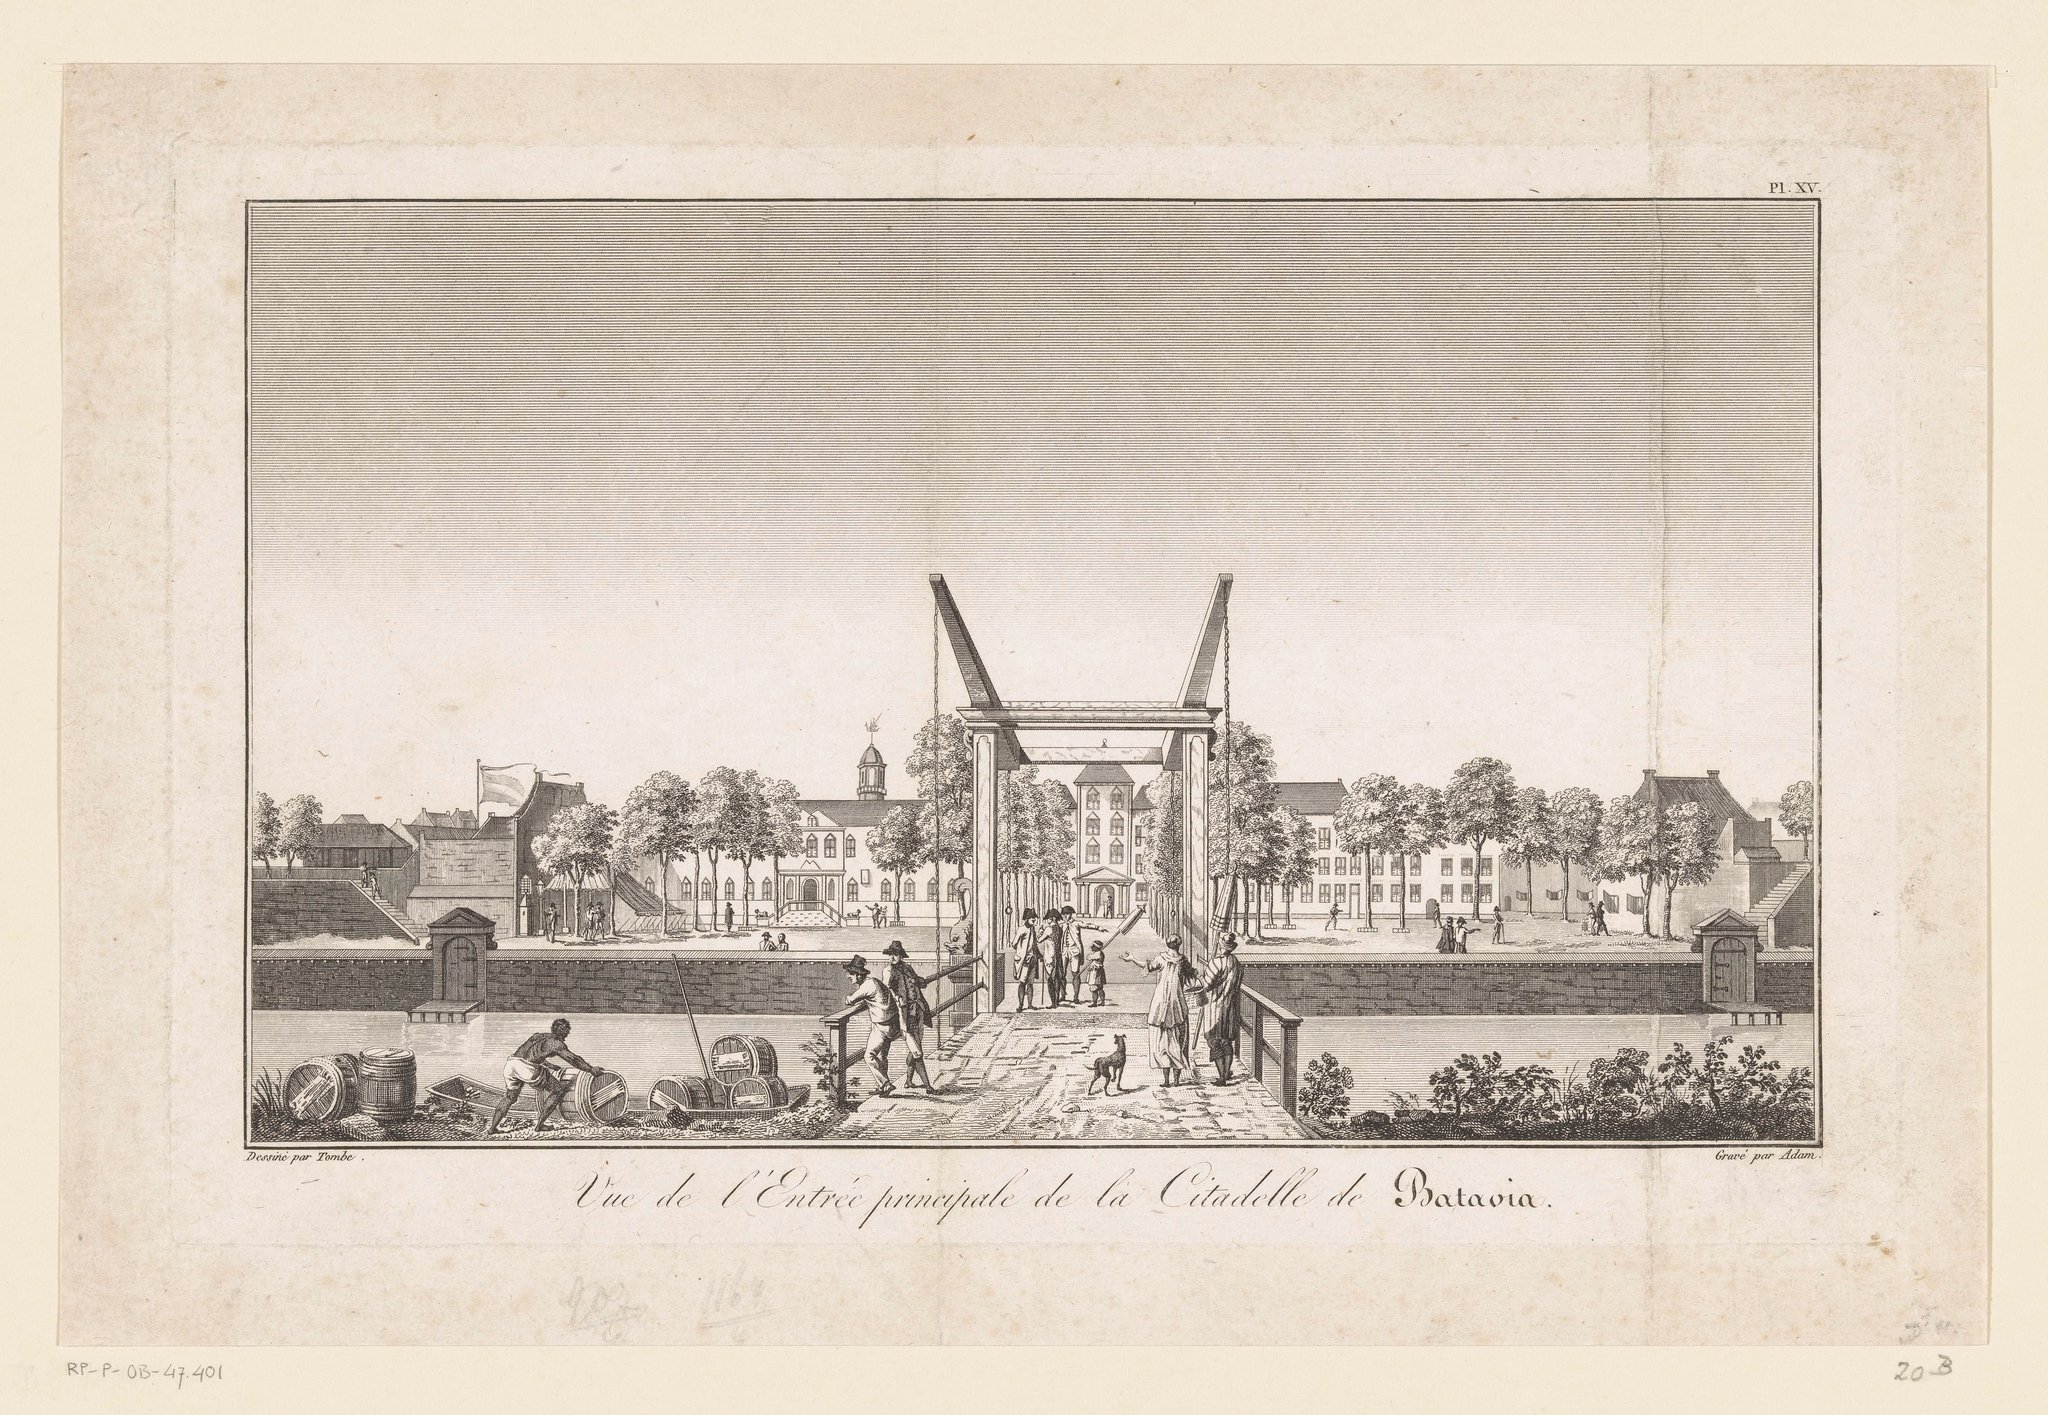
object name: print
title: Vue de l'Entrée principale de la Citadelle de Batavia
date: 1750-1799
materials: paper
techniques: etching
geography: netherlands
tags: drawbridge ~ fortified city, bascule bridge, batavia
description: Titel in ondermarge. Genummerd rechtsboven: Pl. XV.